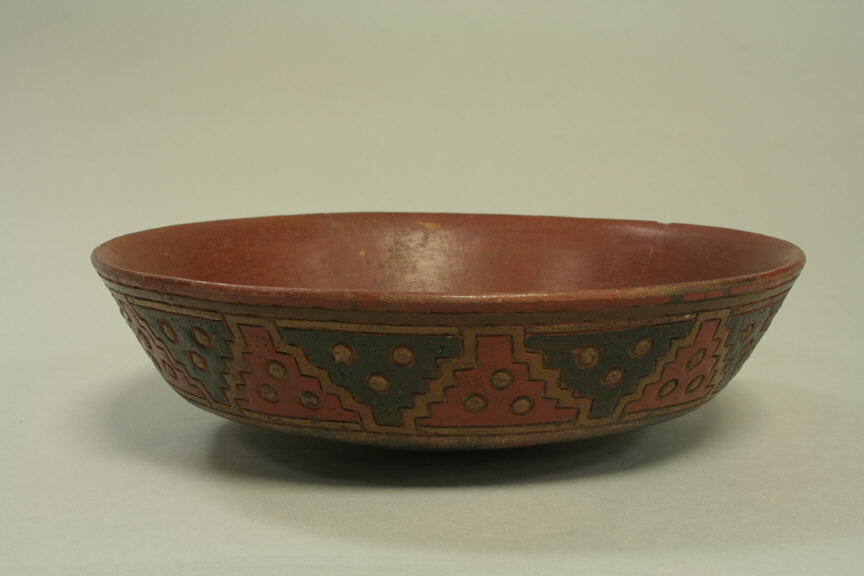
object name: bowl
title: Incised Painted Bowl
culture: paracas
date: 500-101 BCE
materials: ceramic, pigment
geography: peru